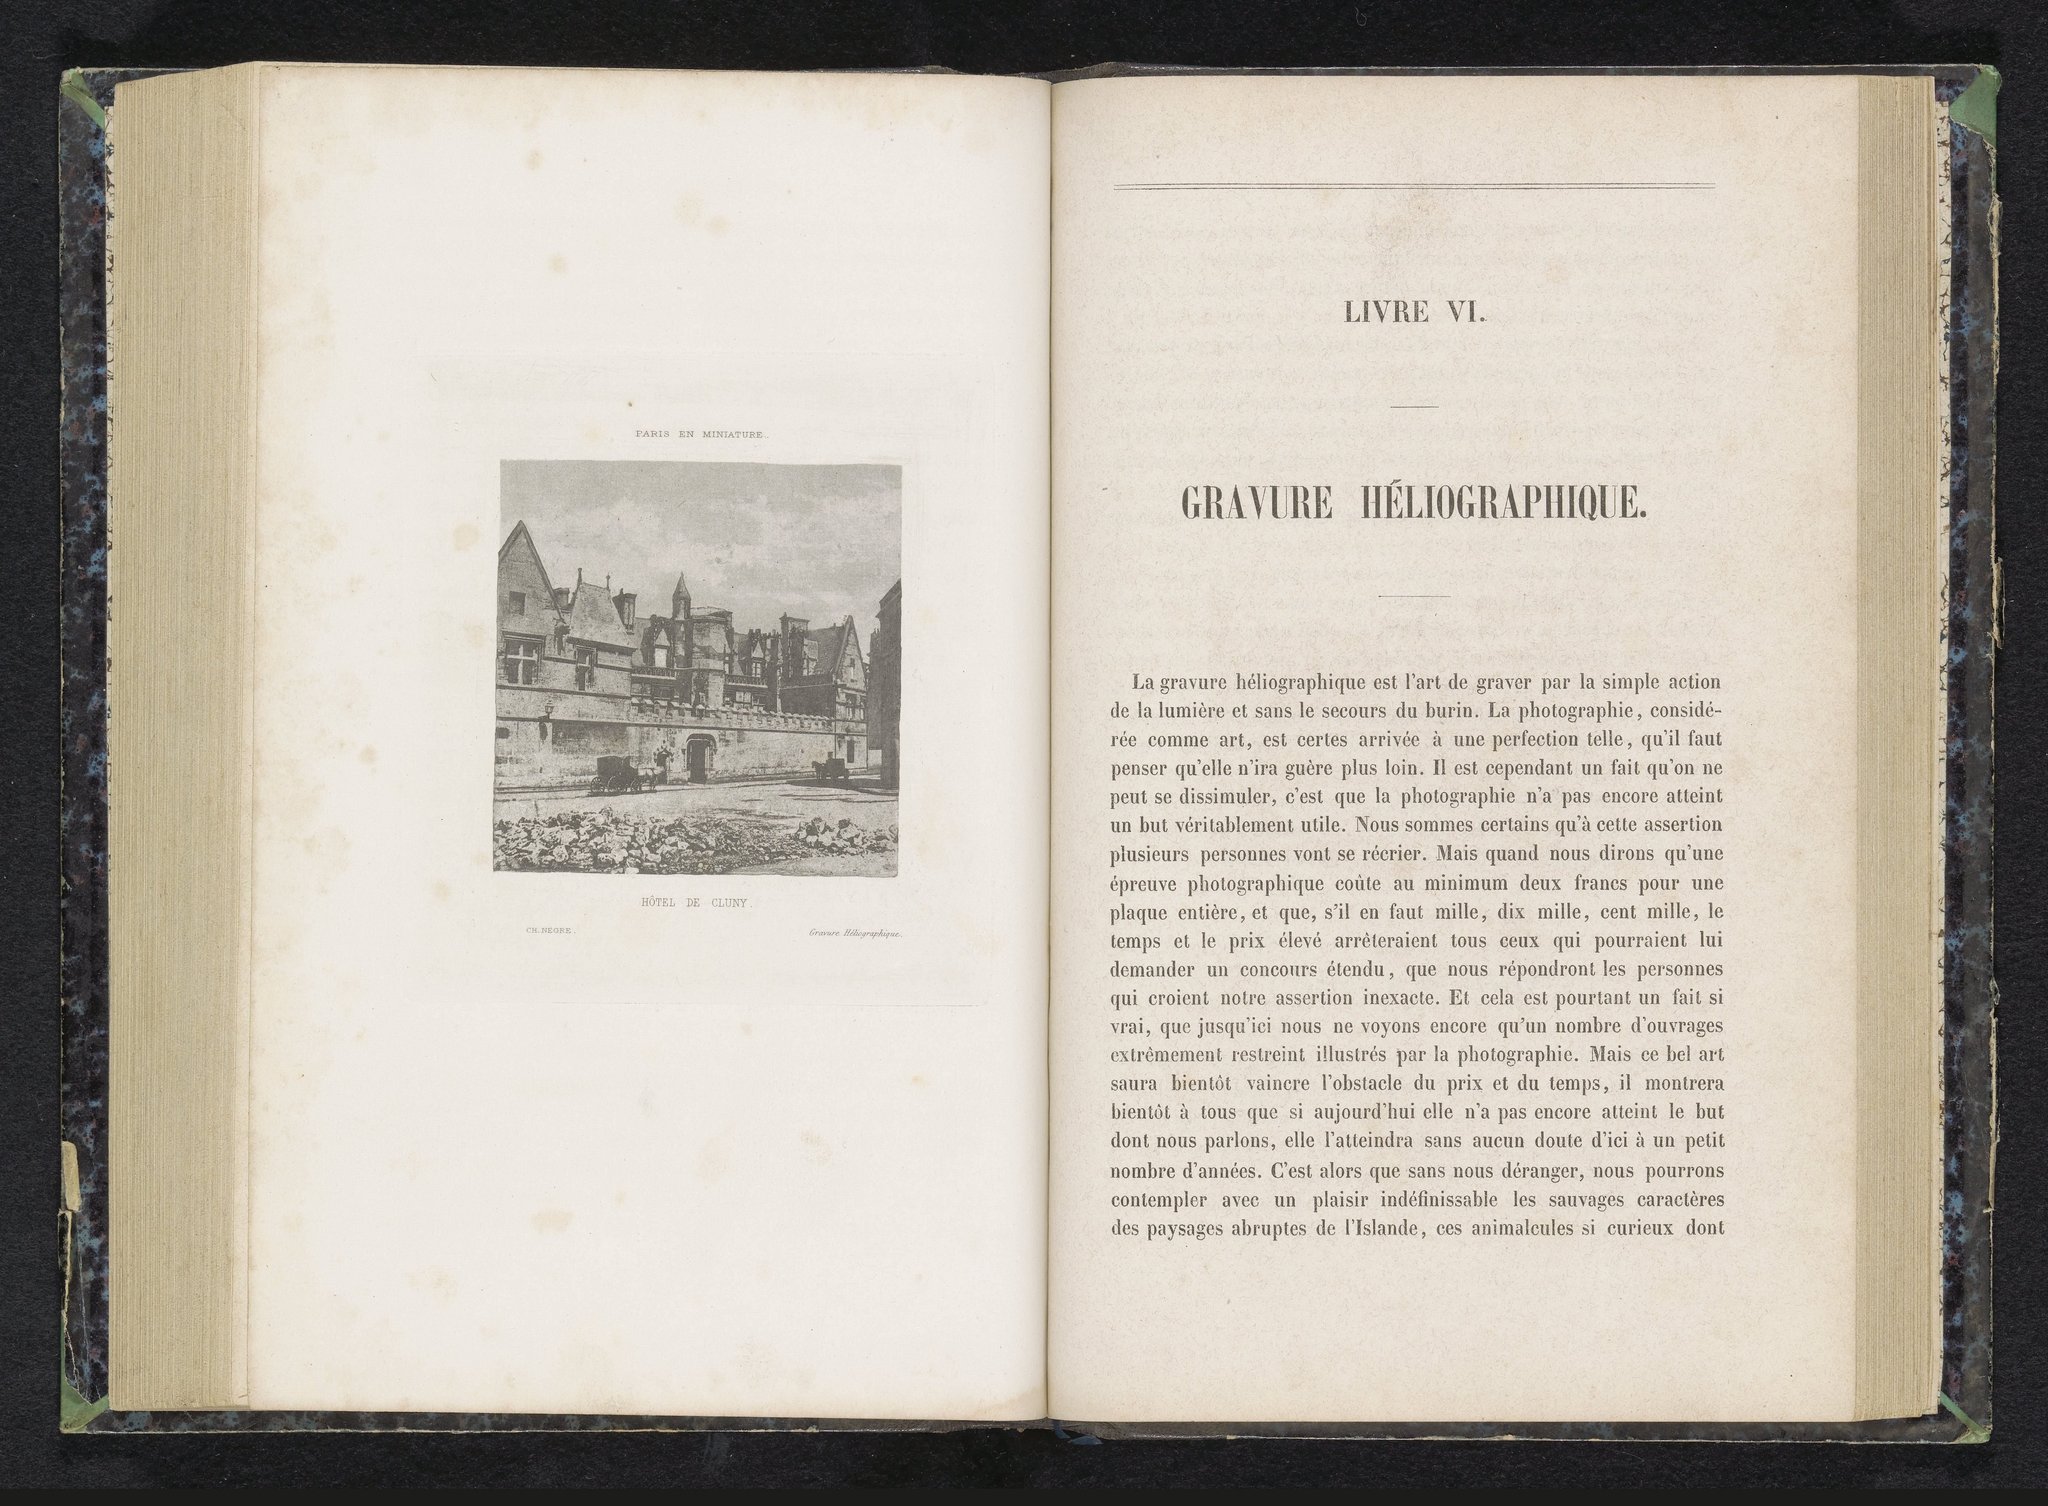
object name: photomechanical print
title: Exterieur van Hôtel de Cluny te Parijs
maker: charles nègre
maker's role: fotograaf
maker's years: 1820-1880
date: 1851-1856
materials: paper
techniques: photoaquatint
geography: paris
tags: four-wheeled, animal-drawn vehicle, e.g.: cab, carriage, coach, permanent exhibition, museum, façade (of house or building)